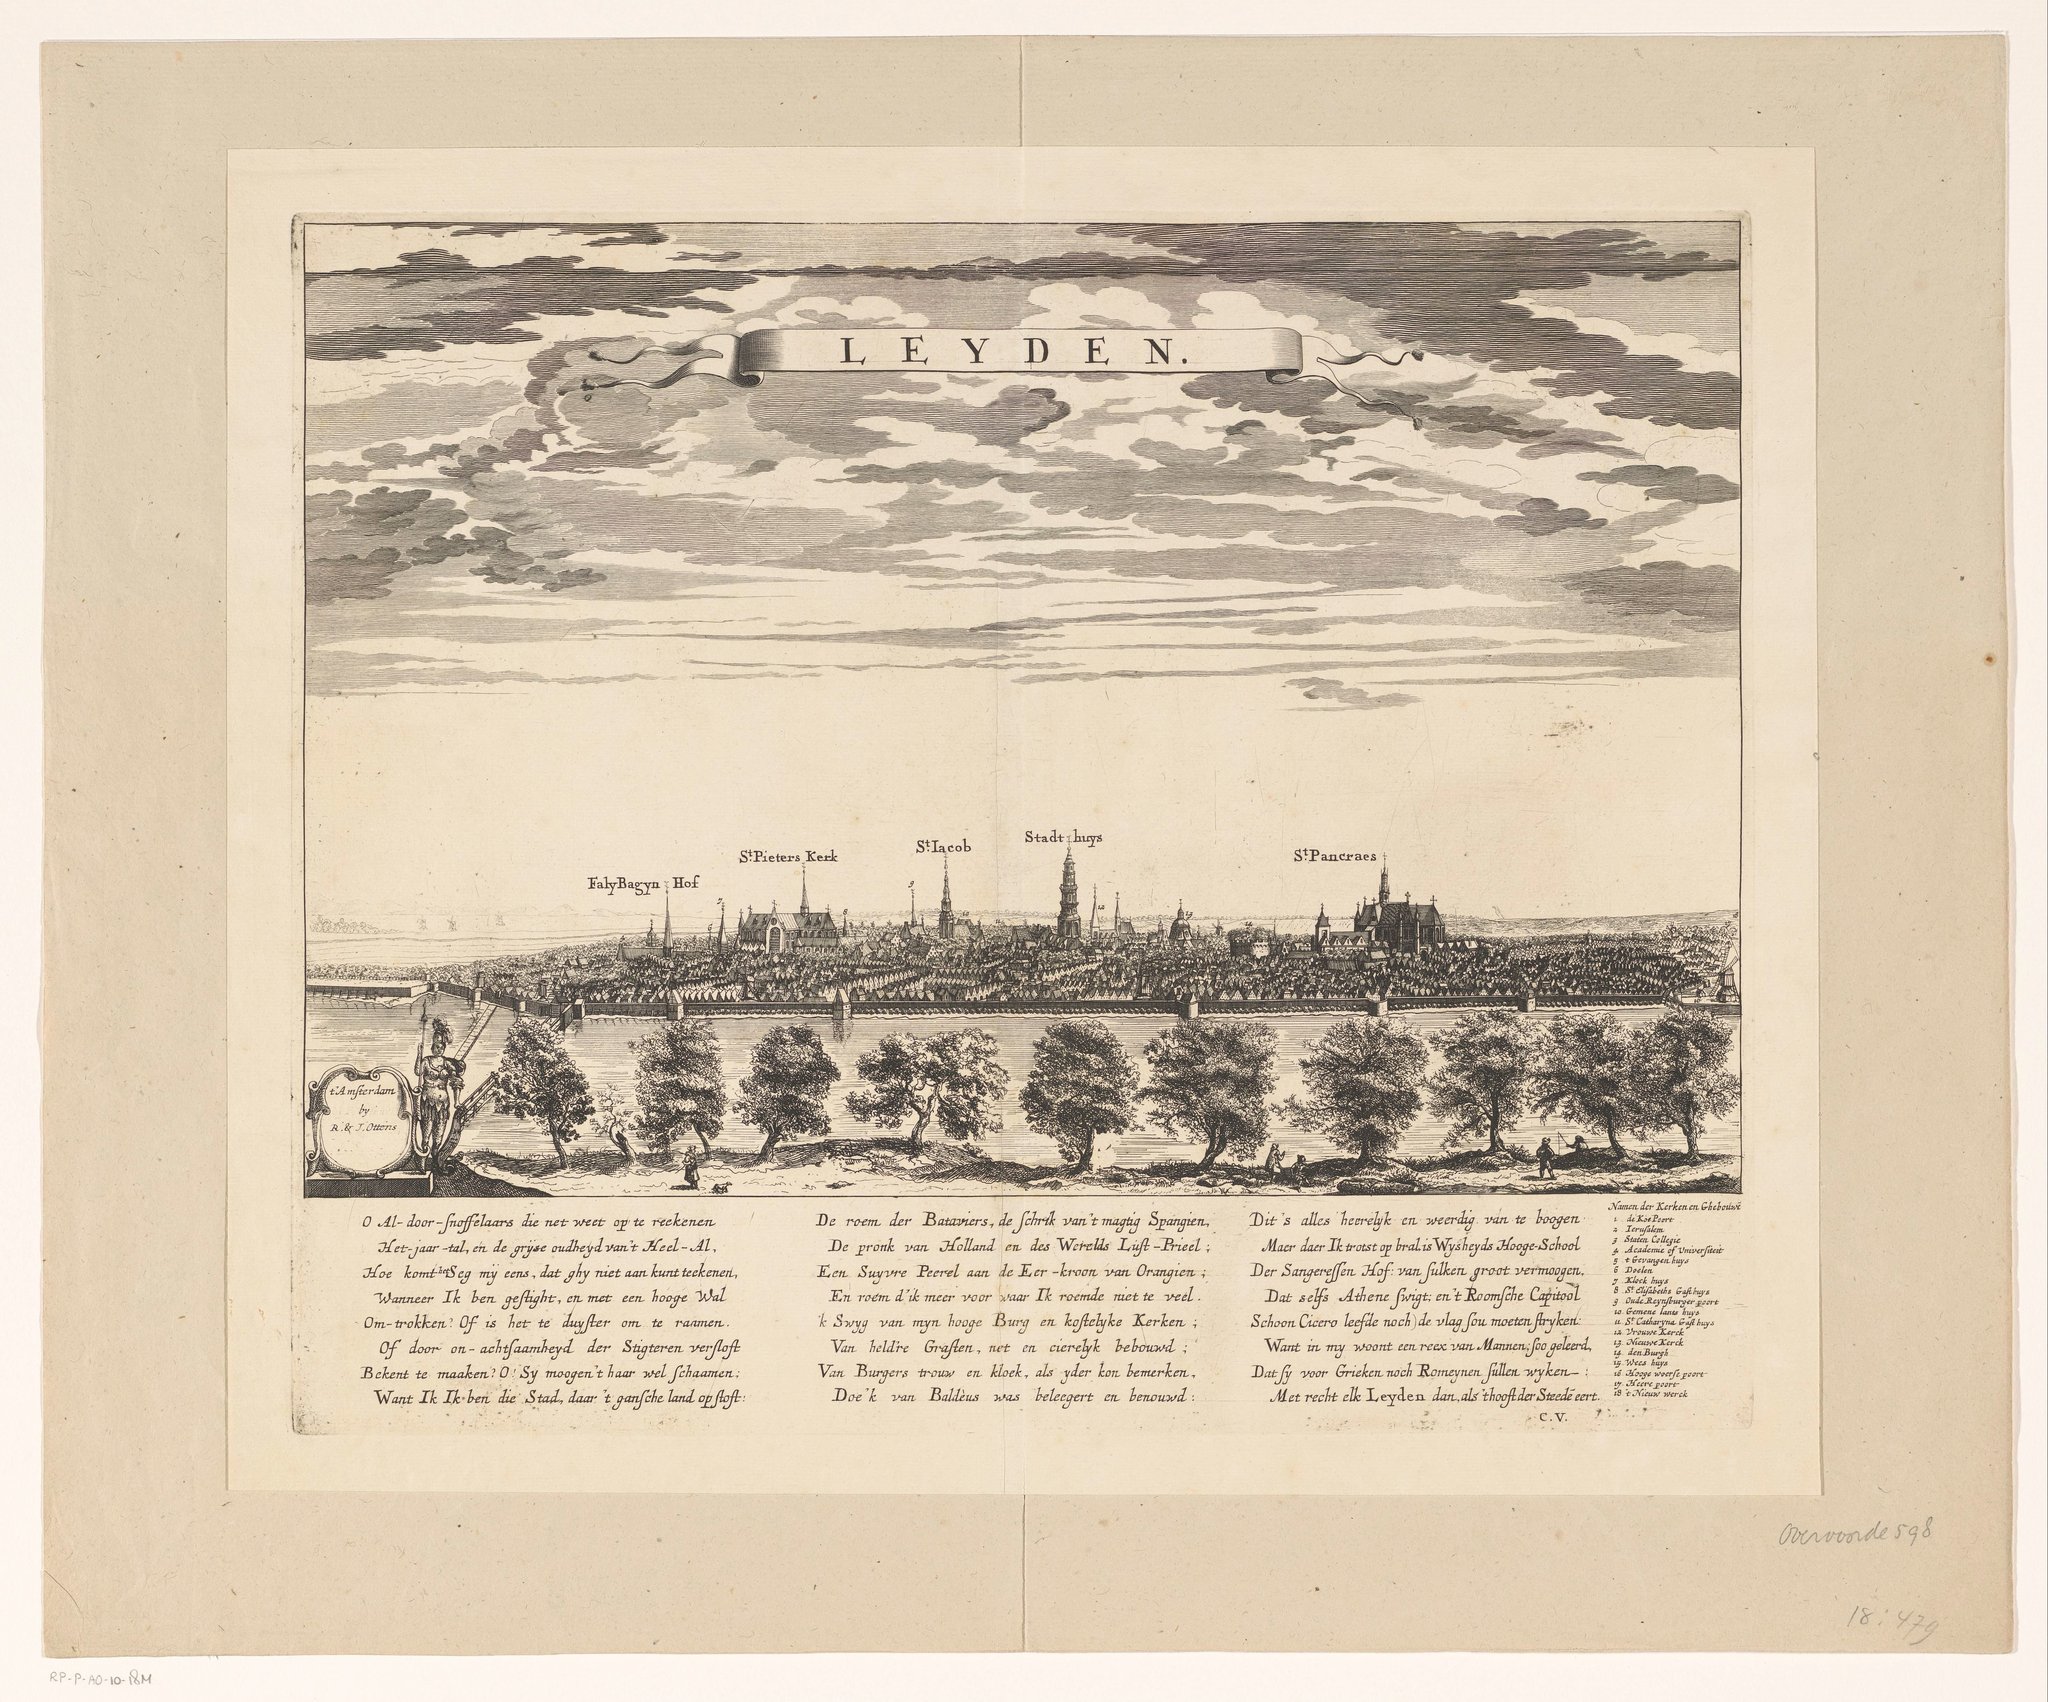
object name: print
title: Stadsgezicht van Leiden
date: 1669-1672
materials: paper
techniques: engraving, etching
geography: amsterdam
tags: prospect of city, town panorama, silhouette of city, leiden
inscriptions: collector's mark: Lugt 2228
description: Gezicht op Leiden. Onder een lofdicht van drie verzen van acht regels in het Nederlands. Rechtsonder de legenda 1-18.